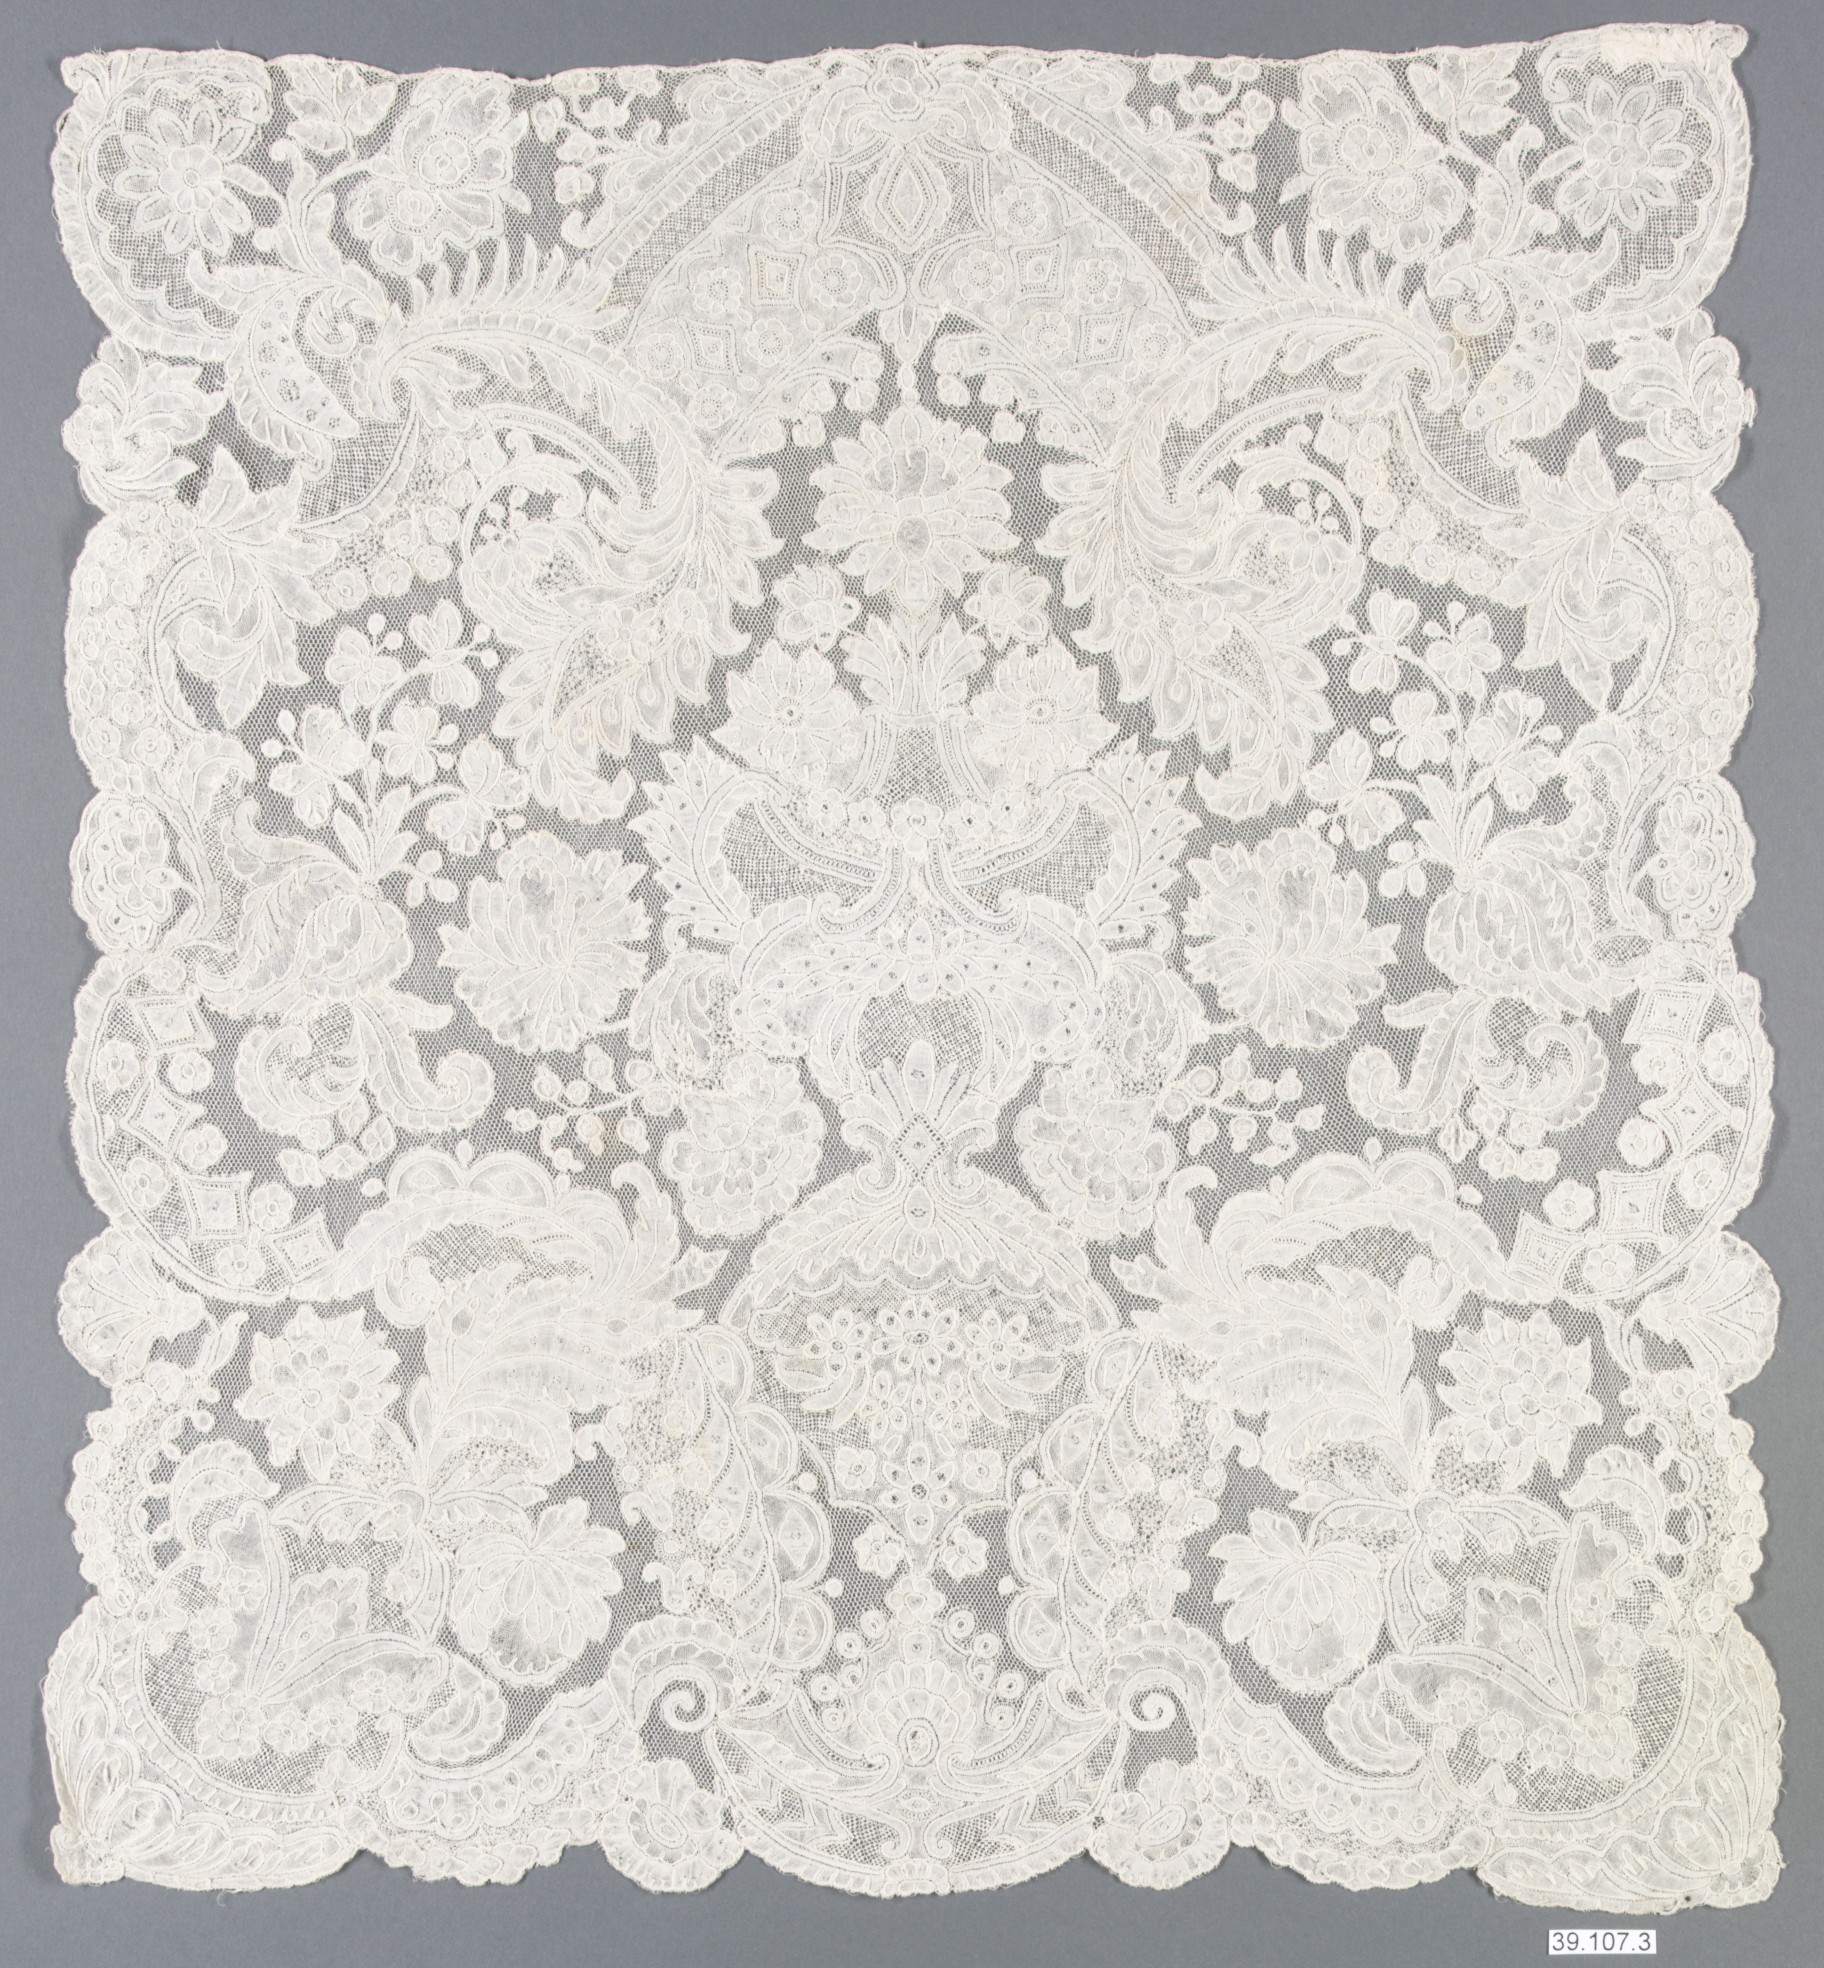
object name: rabat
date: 1720-1740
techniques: lace